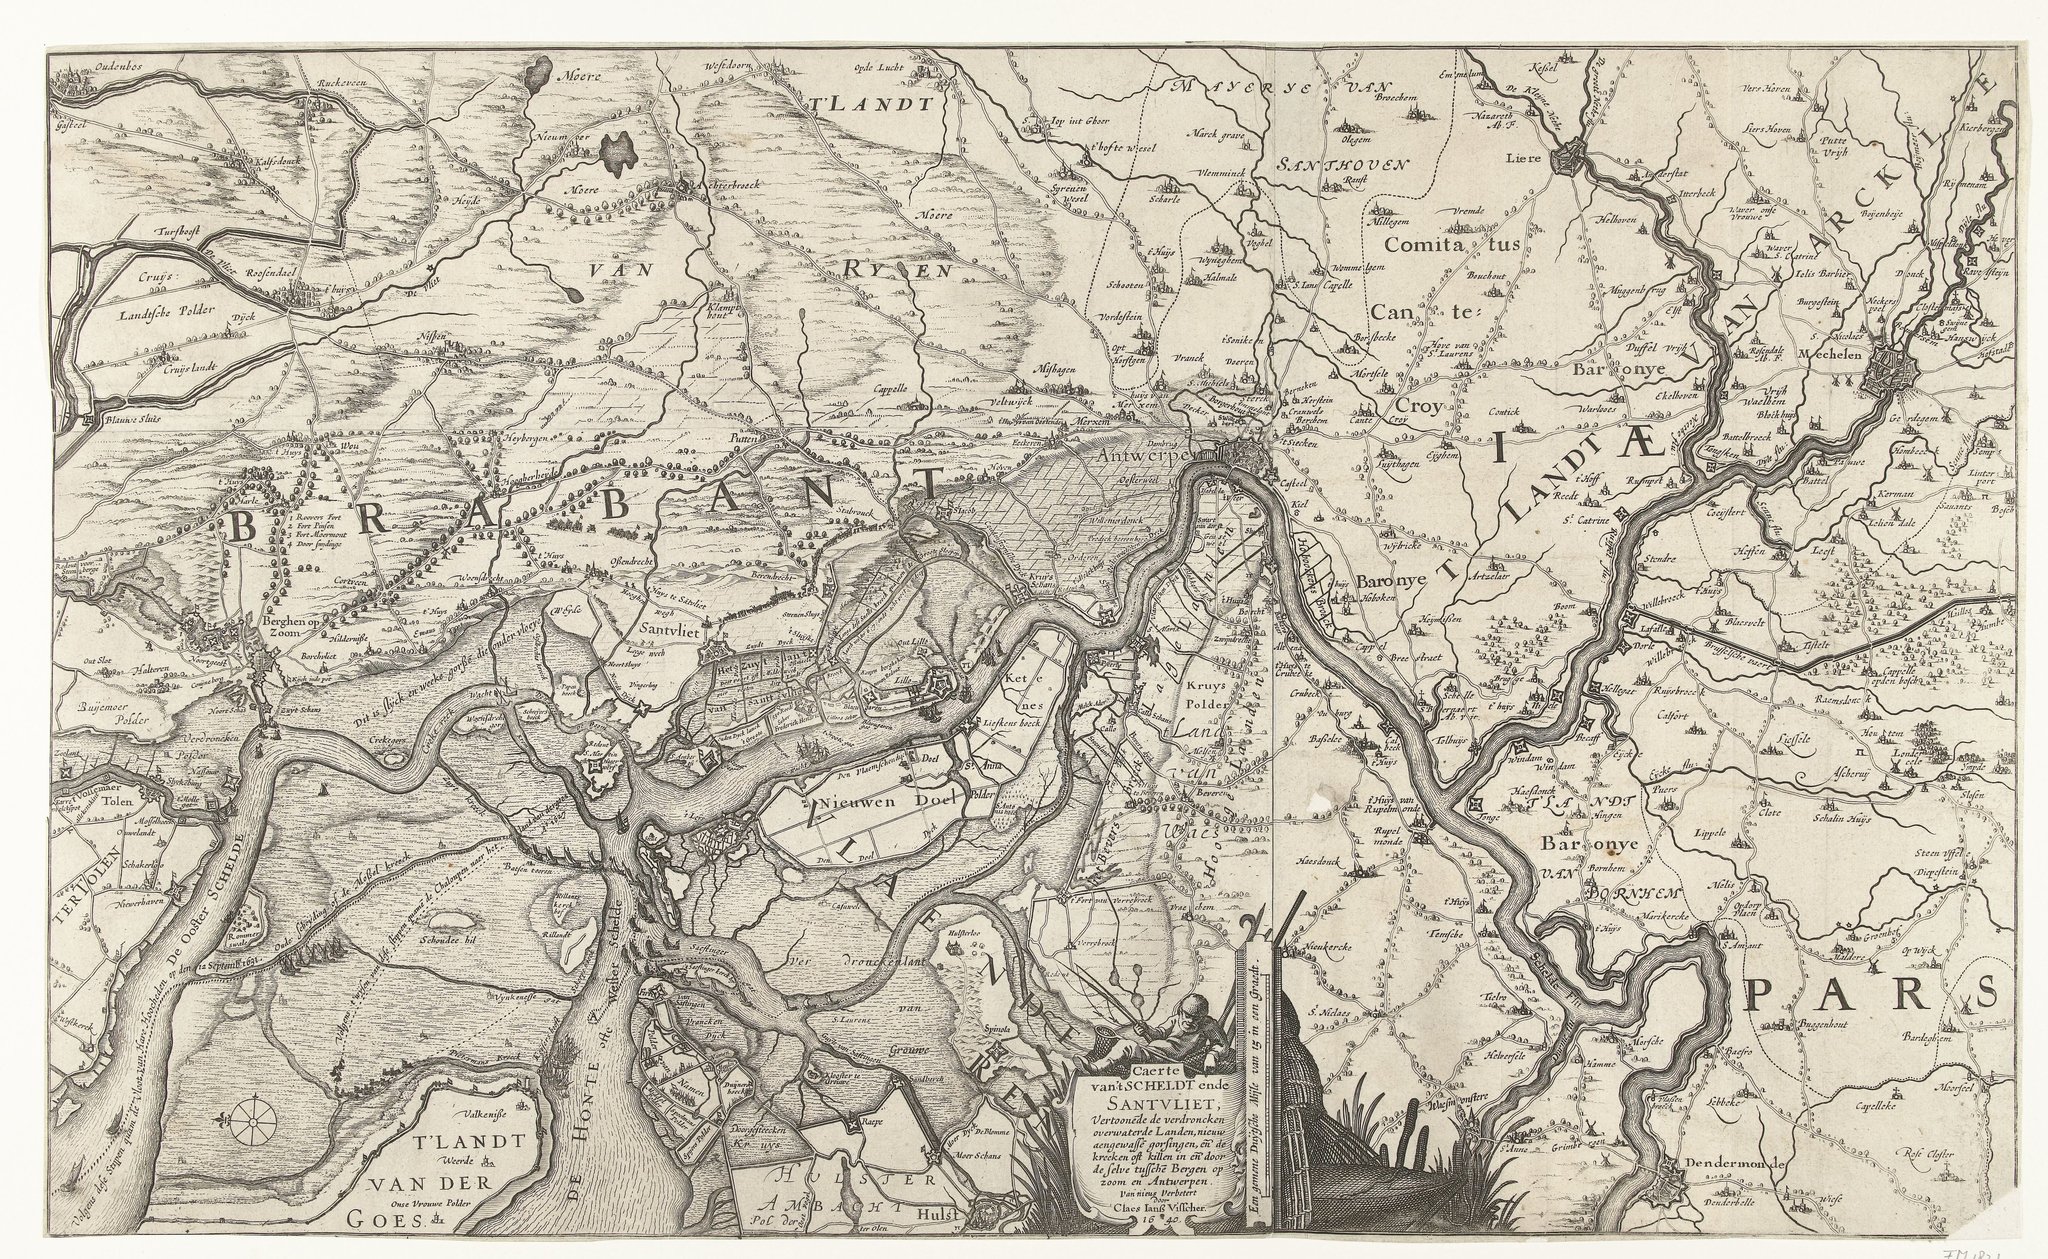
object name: print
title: Map of the Scheldt and the Redoubt at Zandvliet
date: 1627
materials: paper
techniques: etching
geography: amsterdam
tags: maps of separate countries or regions, antwerp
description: Kaart van Schelde, met alle waterwegen, kreken en ondergelopen land tussen Bergen op Zoom, Zandvliet, Antwerpen en Mechelen. Drie bladen aan elkaar geplakt. De oorspronkelijke kaart met de Schelde tussen Bergen op Zoom en Antwerpen is uitgebreid met twee bladen boven en rechts met het gebied tot aan Roosendaal (links) en Mechelen (rechts). Middenonder de cartouche met de titel en een vissertje.